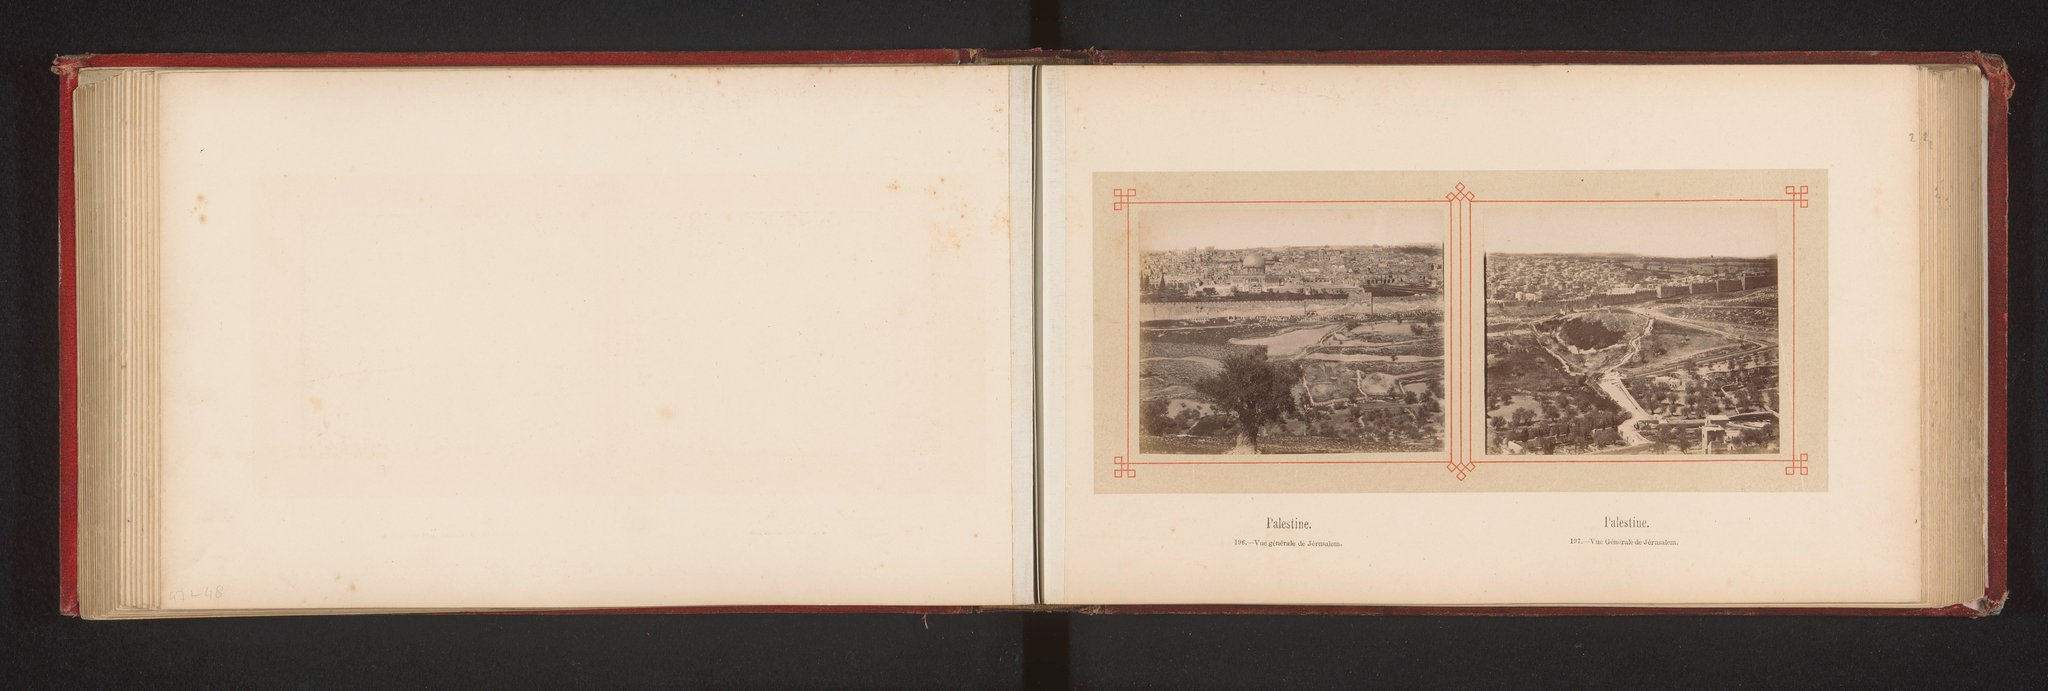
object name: photograph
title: Gezicht op Jeruzalem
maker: félix bonfils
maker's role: fotograaf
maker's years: 1831-1885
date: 1873-1878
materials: photographic support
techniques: albumen print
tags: city-view in general; 'veduta'